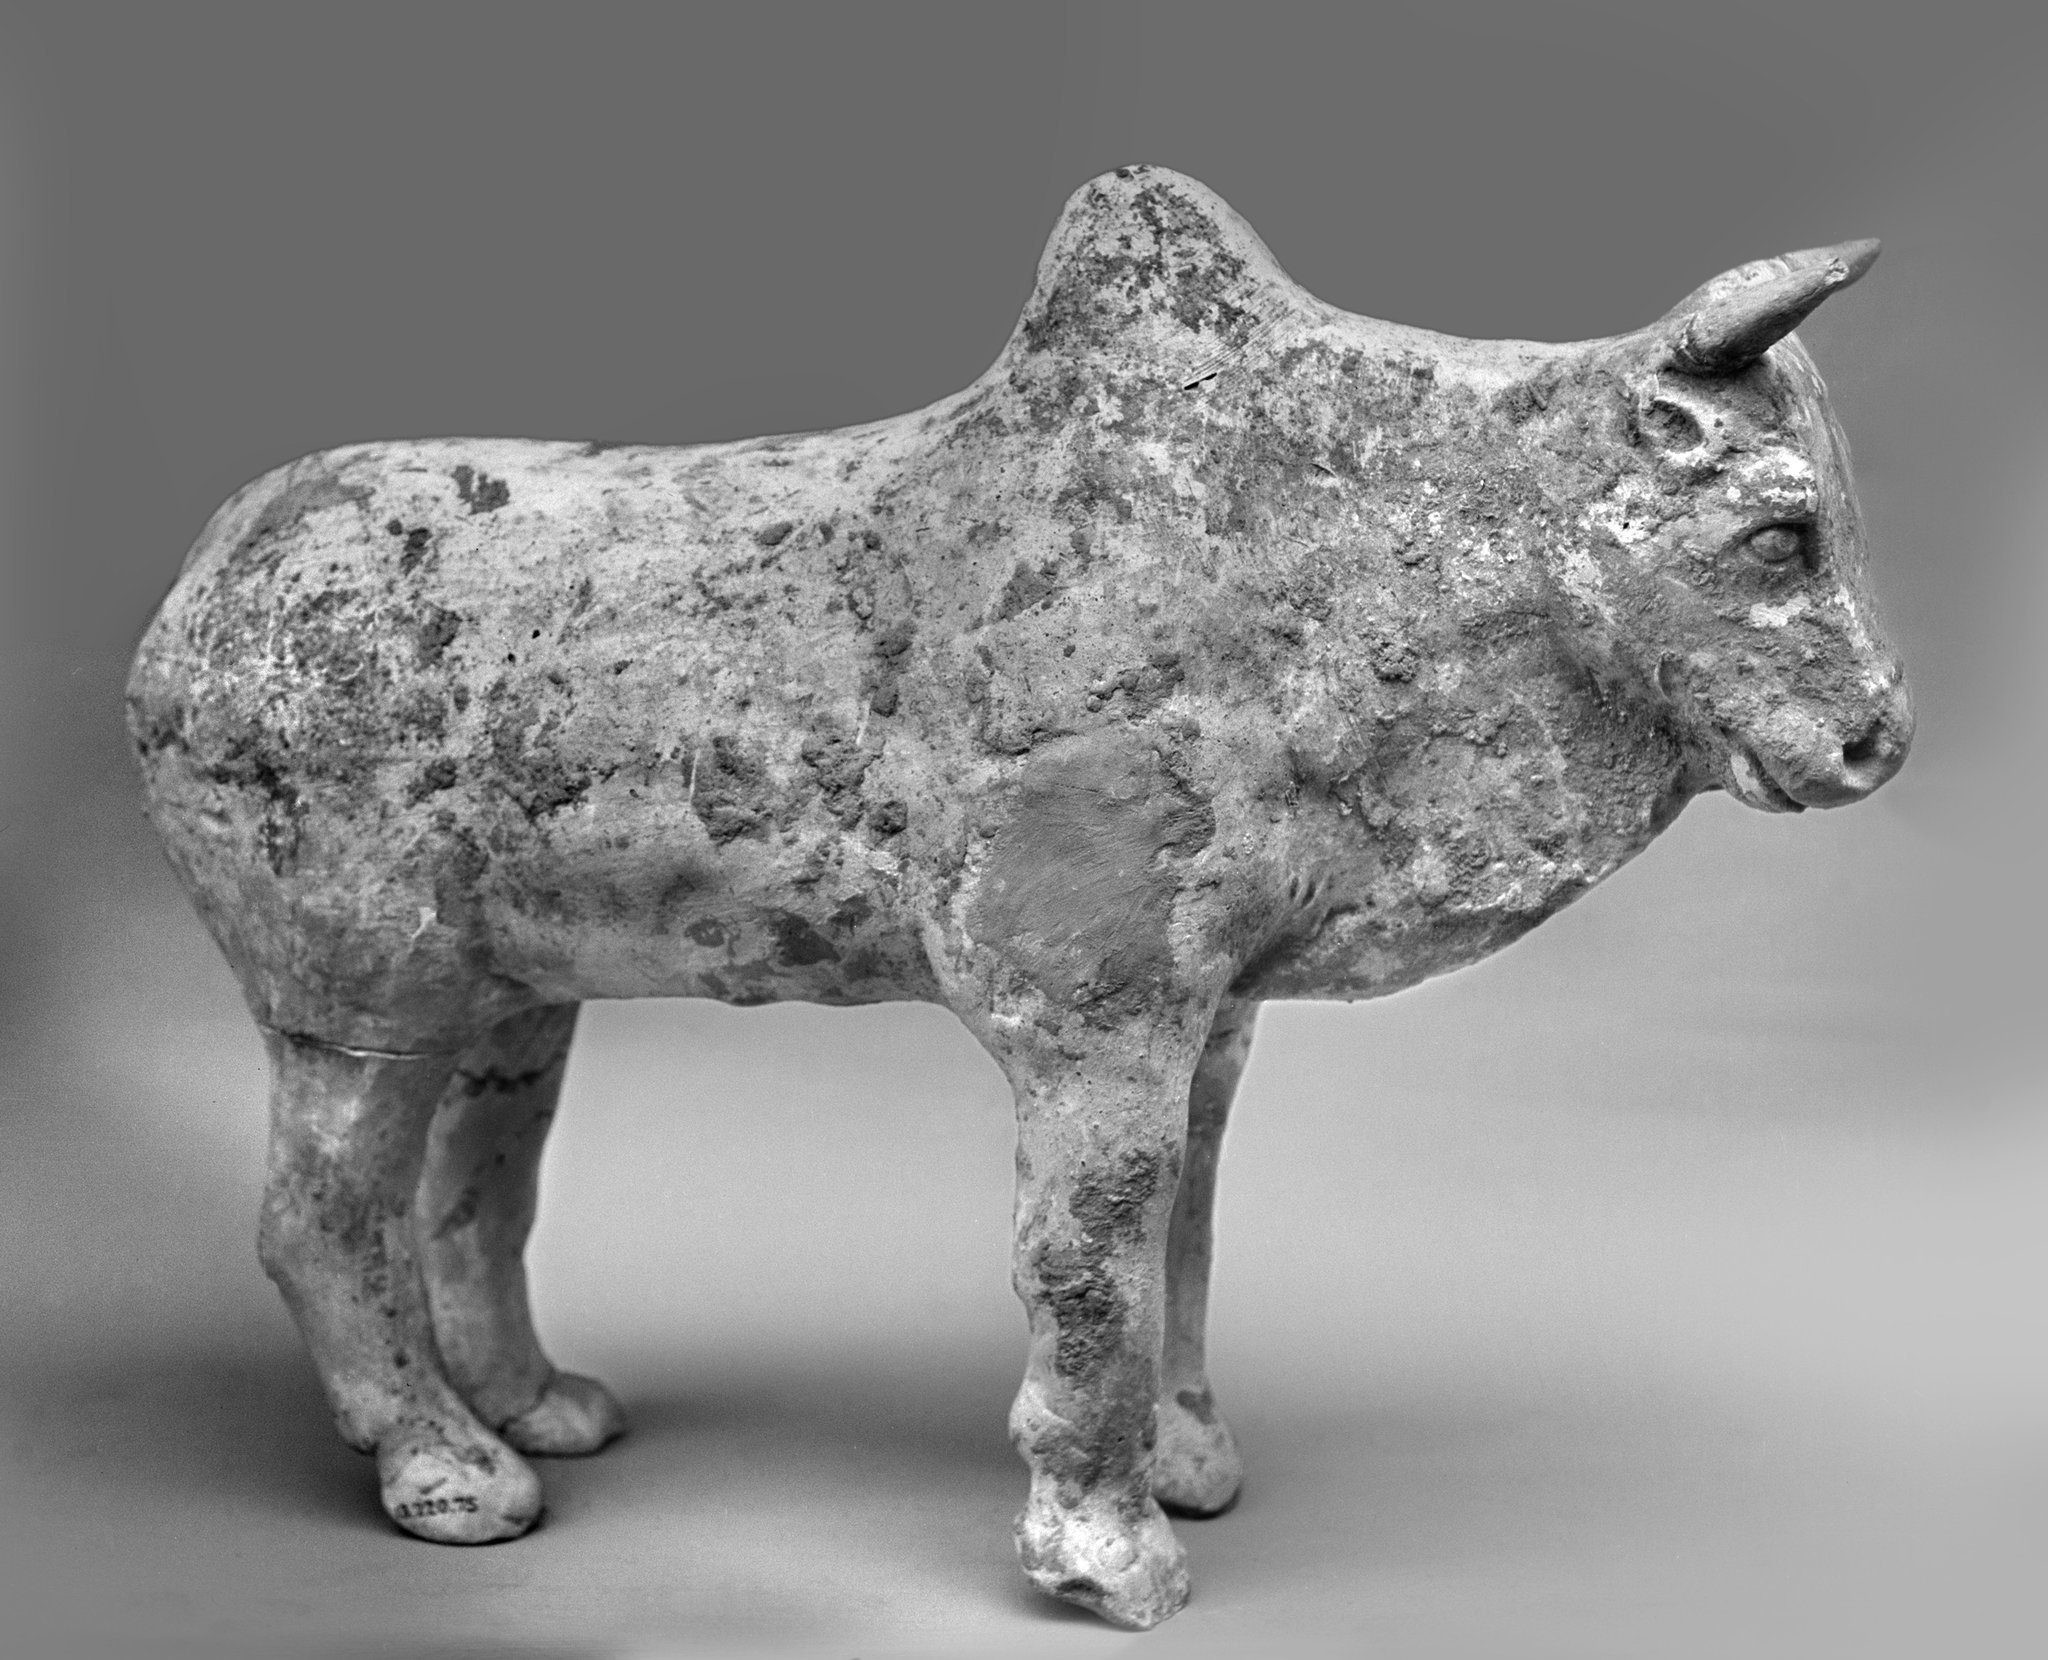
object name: figure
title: Ox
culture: chinese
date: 601-800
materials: earthenware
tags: ox